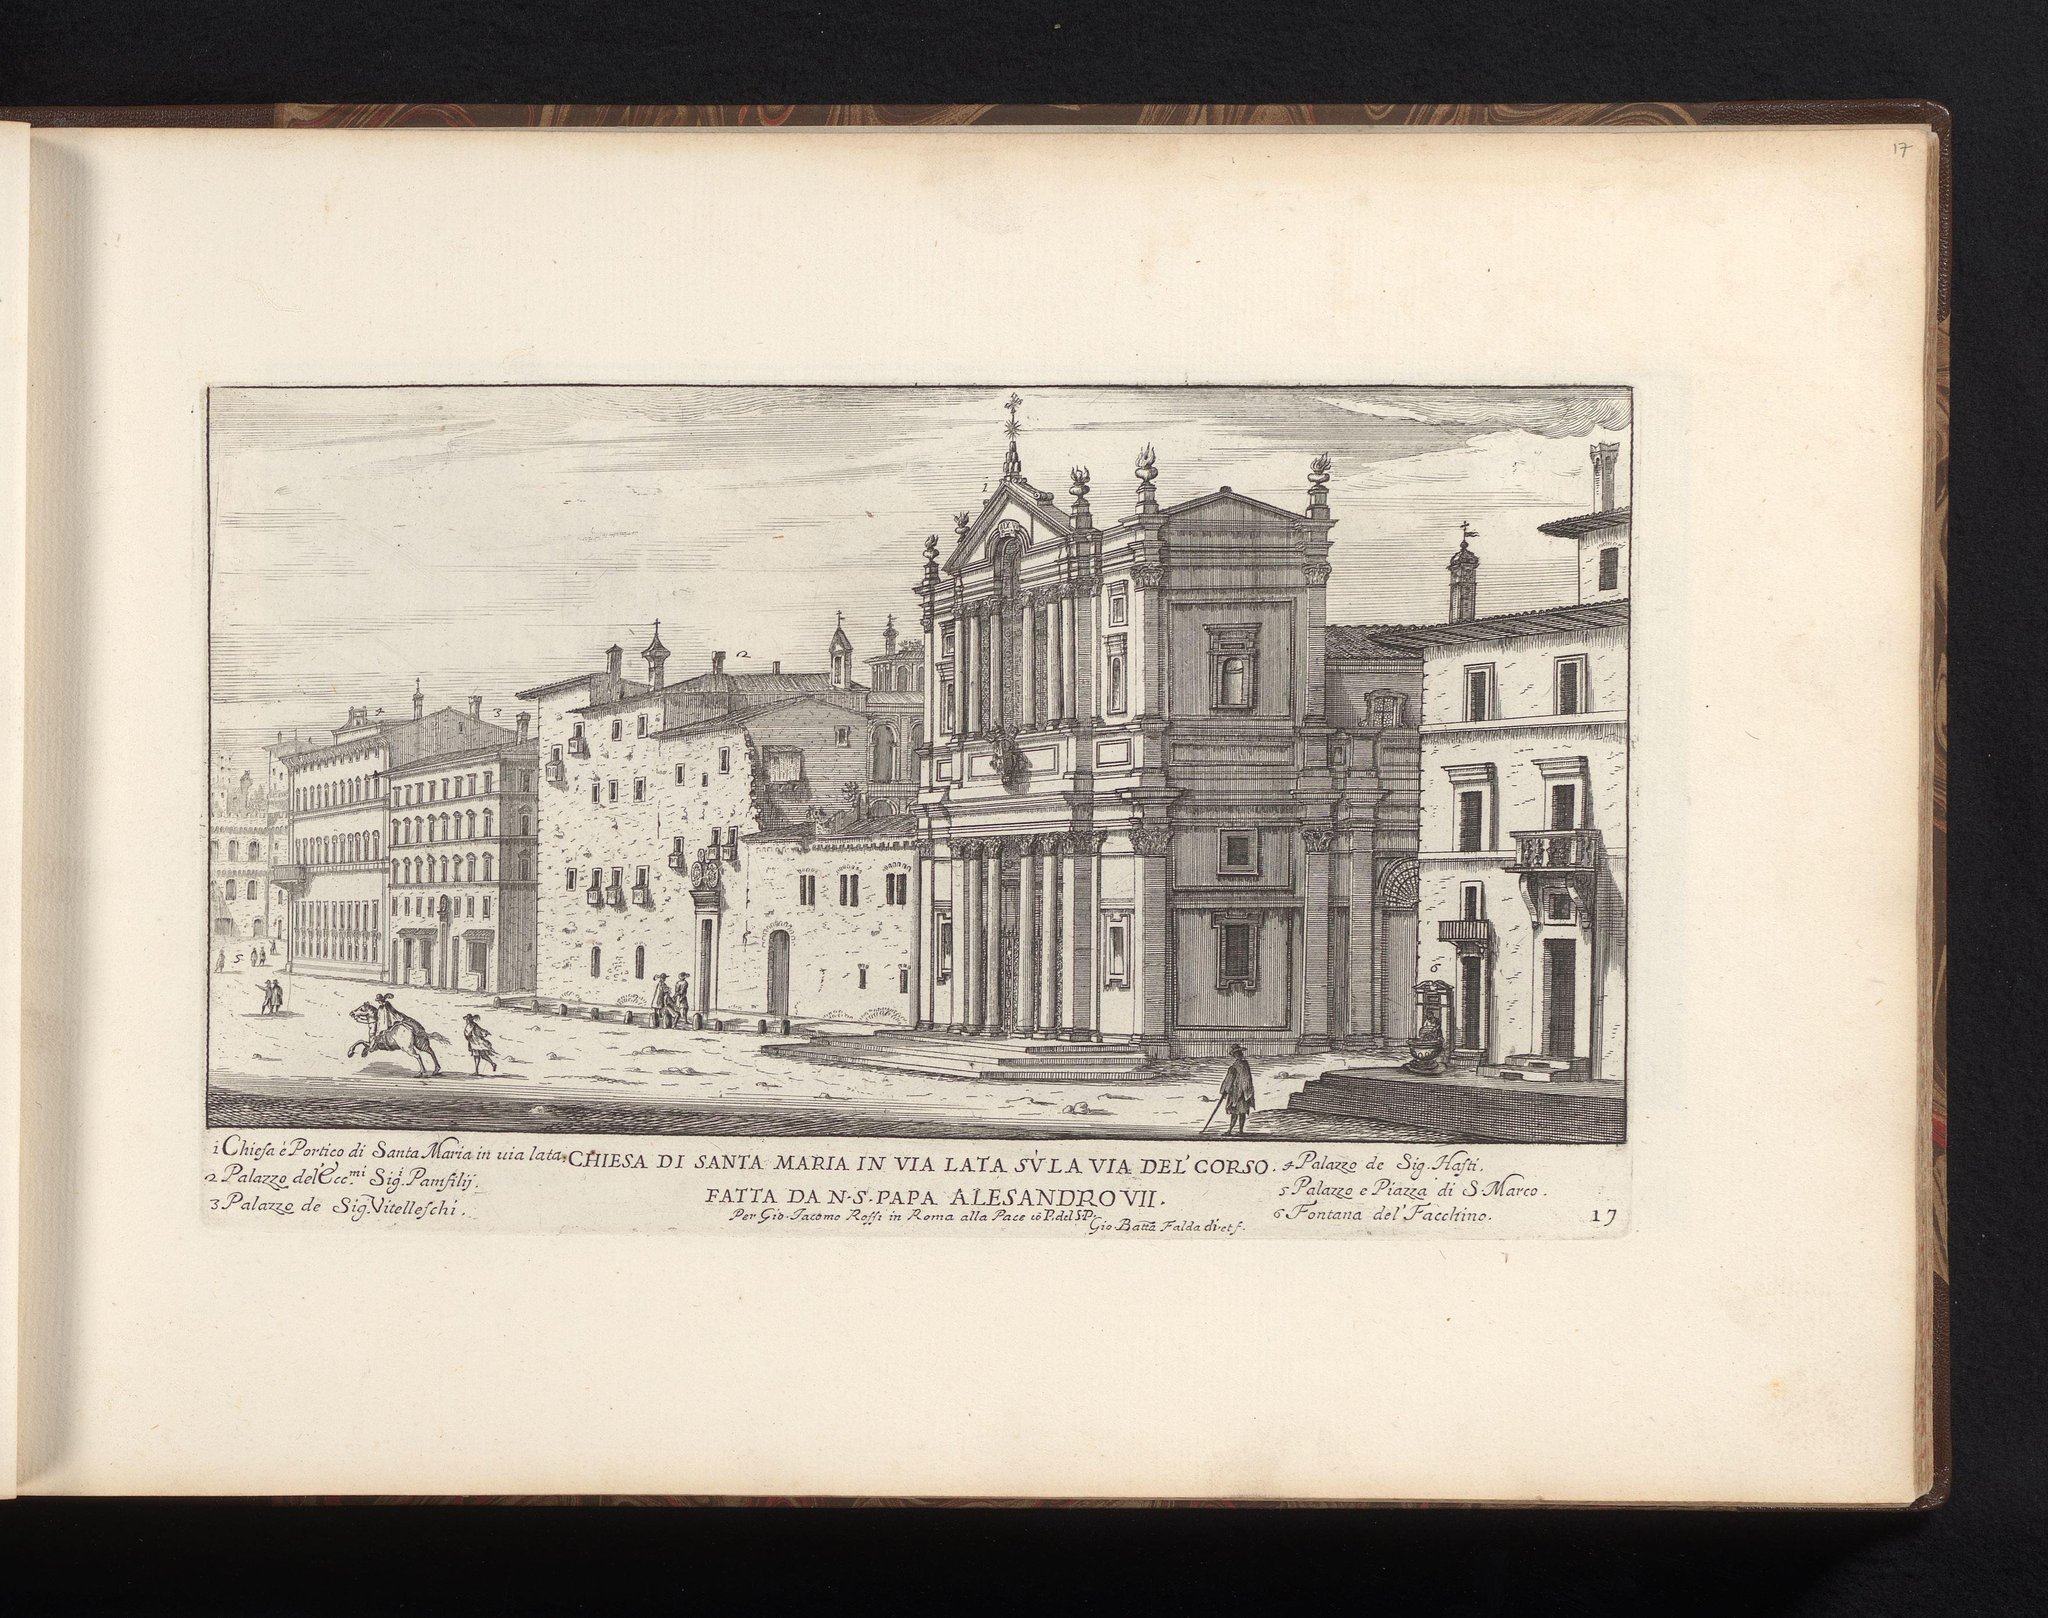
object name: album leaf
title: Il nuovo teatro di Roma moderna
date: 1665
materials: paper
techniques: etching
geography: vatican city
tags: city-view, and landscape with man-made constructions, church (exterior), rome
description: Deze prent maakt deel uit van een reeks van 35 prenten met voorstellingen van gebouwen in Rome. Samen met vier andere reeksen vormt het de grote reeks: 'Il nuovo teatro di Roma moderna'.